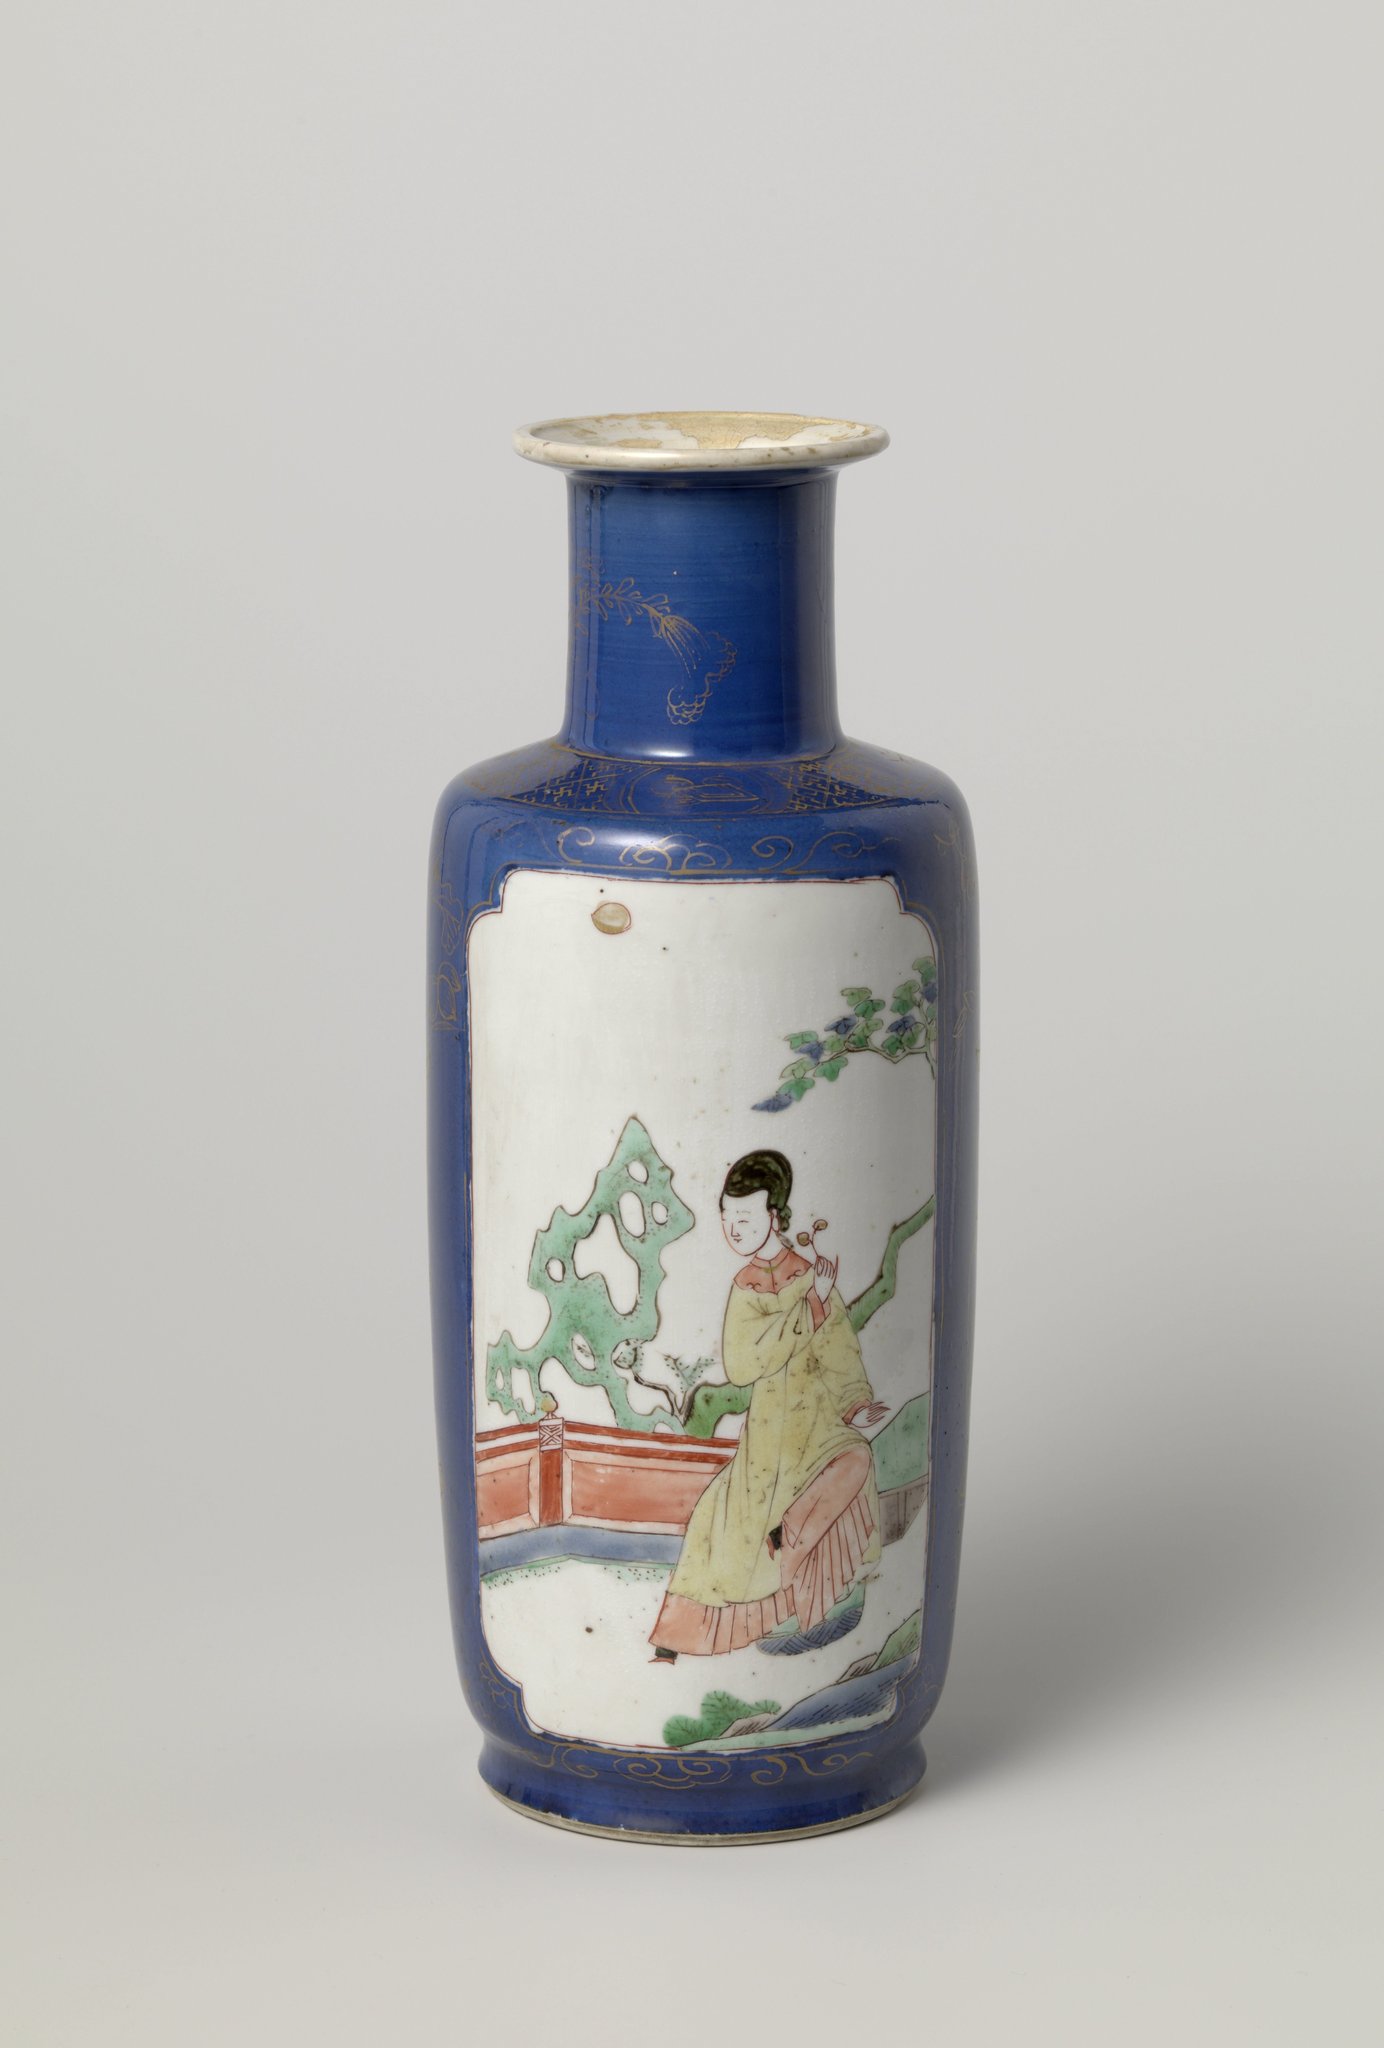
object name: vase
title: Cylindrical vase with powder blue and a woman on a terrace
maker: Anonymous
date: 1700-1724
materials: cobalt, glaze, gold, paint, porcelain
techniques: firing, gilding, turning, vitrification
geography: china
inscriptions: label: ‘Collection S. Alberge-La Haye 1750’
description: The woman depicted on this vase is playing a pipa. A legend links this instrument to Princess Liu Xijun (123?–101 BCE), whom the emperor sent off to marry the king of the Wusun. The emperor ordered a stringed instrument to be made that could be played on horseback during her long journey. Liu also wrote the earliest poem attributable to a named woman in which she describes her homesickness.